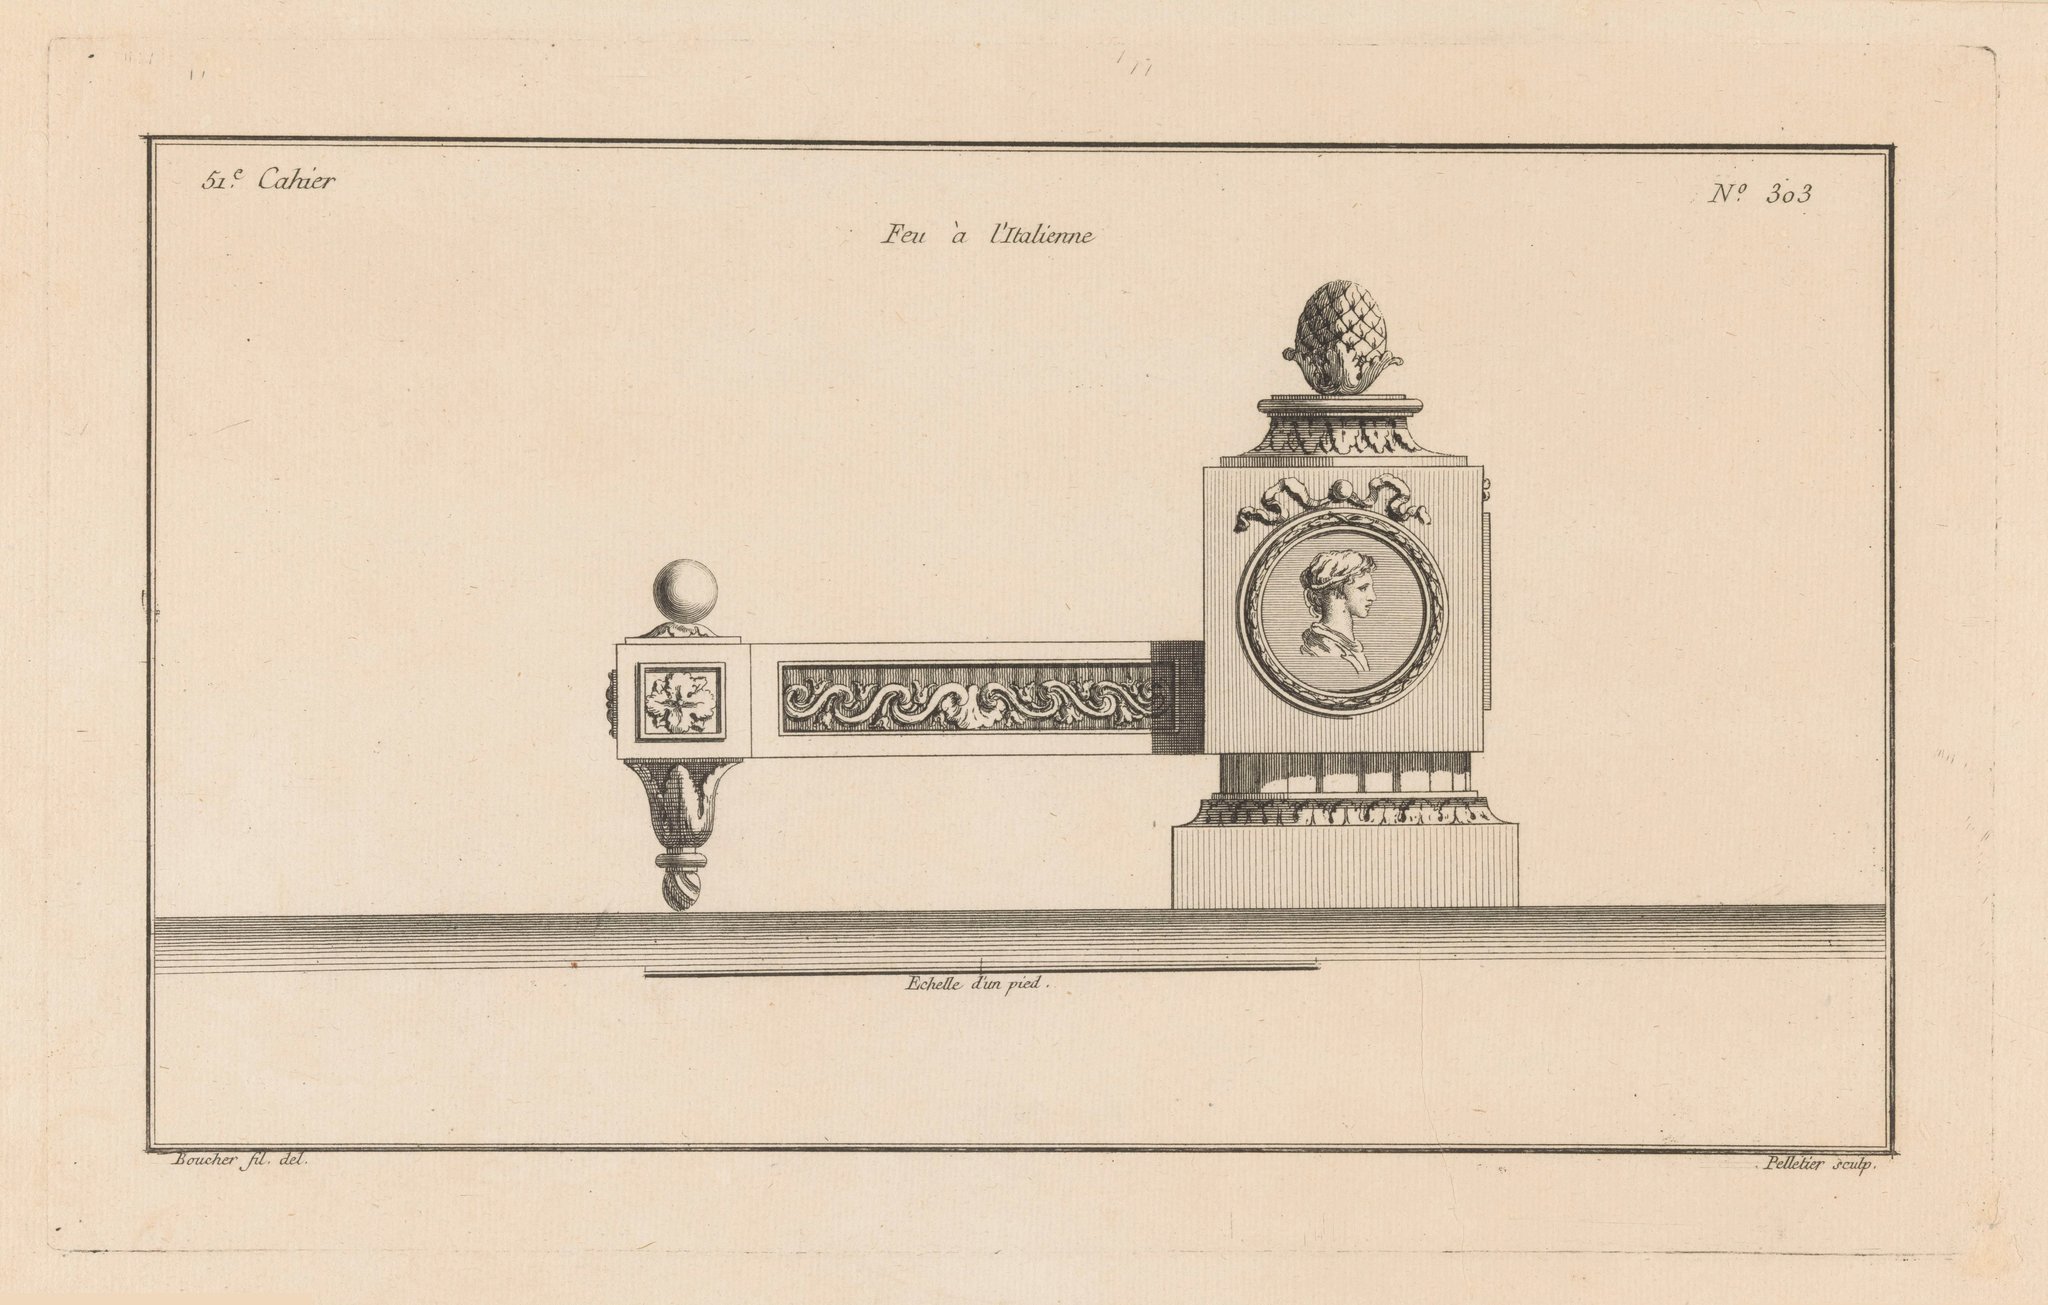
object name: print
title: Feu à l'Italienne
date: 1772-1779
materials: paper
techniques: engraving, etching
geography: paris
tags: andiron, fire-dog, fruits: pineapple, ornament ~ medallion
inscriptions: collector's mark: Lugt 2228, collector's mark: Lugt 2760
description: Een geornamenteerde vuurbok met portret in profil in een rond medaillon en een dennenappel. Prentnummer 303.